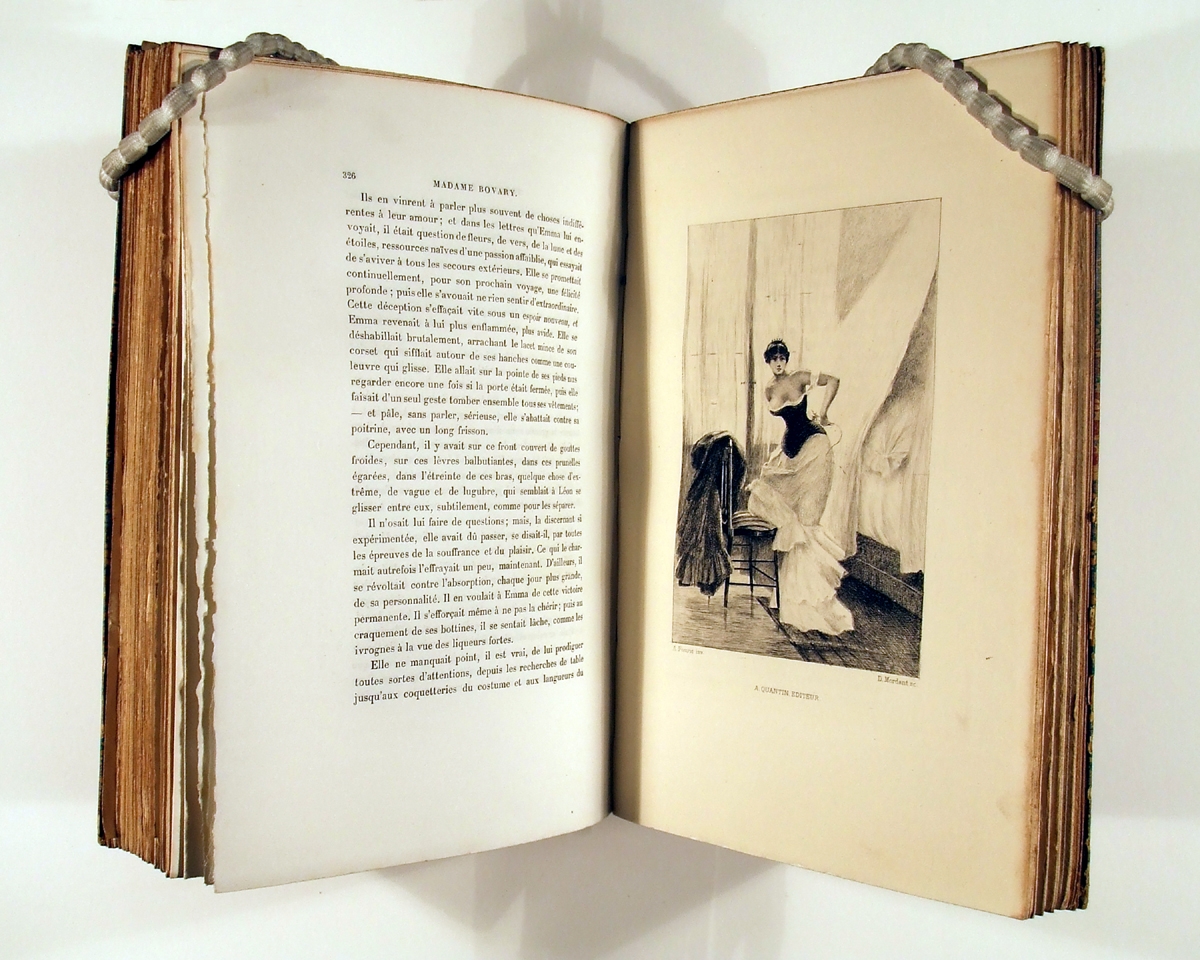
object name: book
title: Madame Bovary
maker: gustave flaubert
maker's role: author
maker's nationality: french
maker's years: 1821-1880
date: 1885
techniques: etching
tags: women